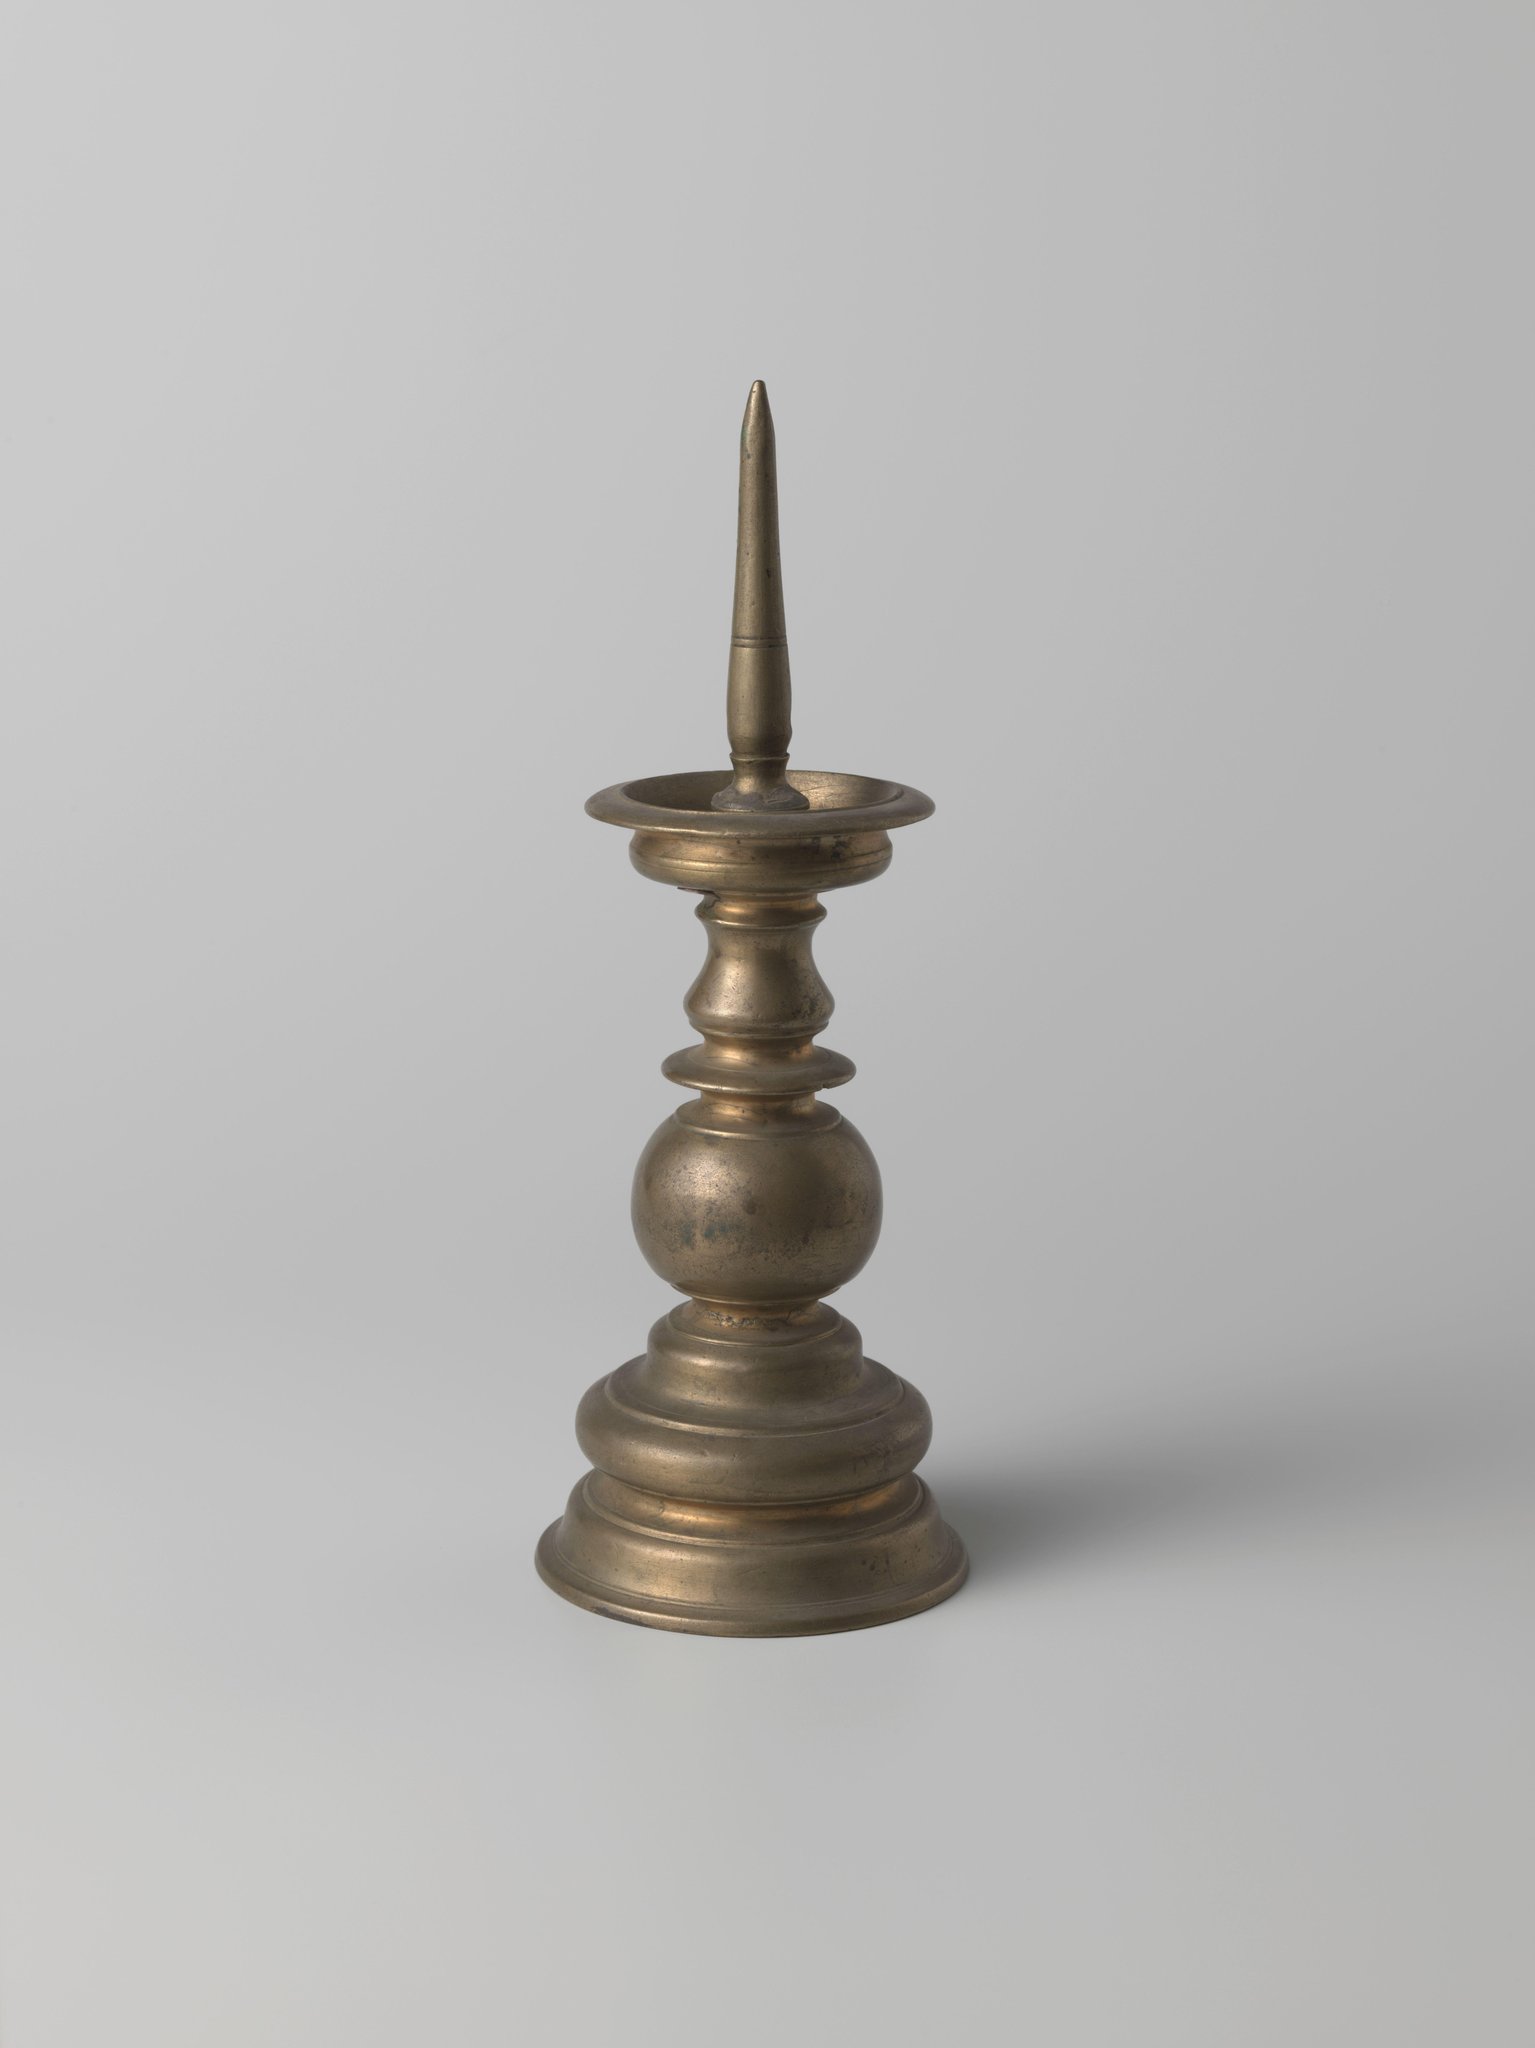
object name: candlestick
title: Kandelaar met geprofileerde stam en voet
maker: Anonymous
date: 1600-1699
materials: brass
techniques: casting, riveted, turning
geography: nuremberg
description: Voet, stam en vetvanger zijn in één geheel gegoten. De kaarsenpin is met de bodem van de vetvanger op twee plaatsen in de vetvanger geklonken. De geprofileerde pin heeft onderaan een horizontaal gat, dienende om de pin er op of er af te draaien. De geprofileerde konische voet gaat over in een stam, bestaande uit een bol, een knoop en een kleine baluster, en vervolgens in een geprofileerde vetvanger met een rib aan de binnenzijde van de uitstekende rand. Alle delen zijn met gegroefde ringen versierd. Voet en stam zijn van binnen hol. De kaarsenpin is gesoldeerd, de bodem van de vetvanger is (met rood koper) opnieuw geklonken.